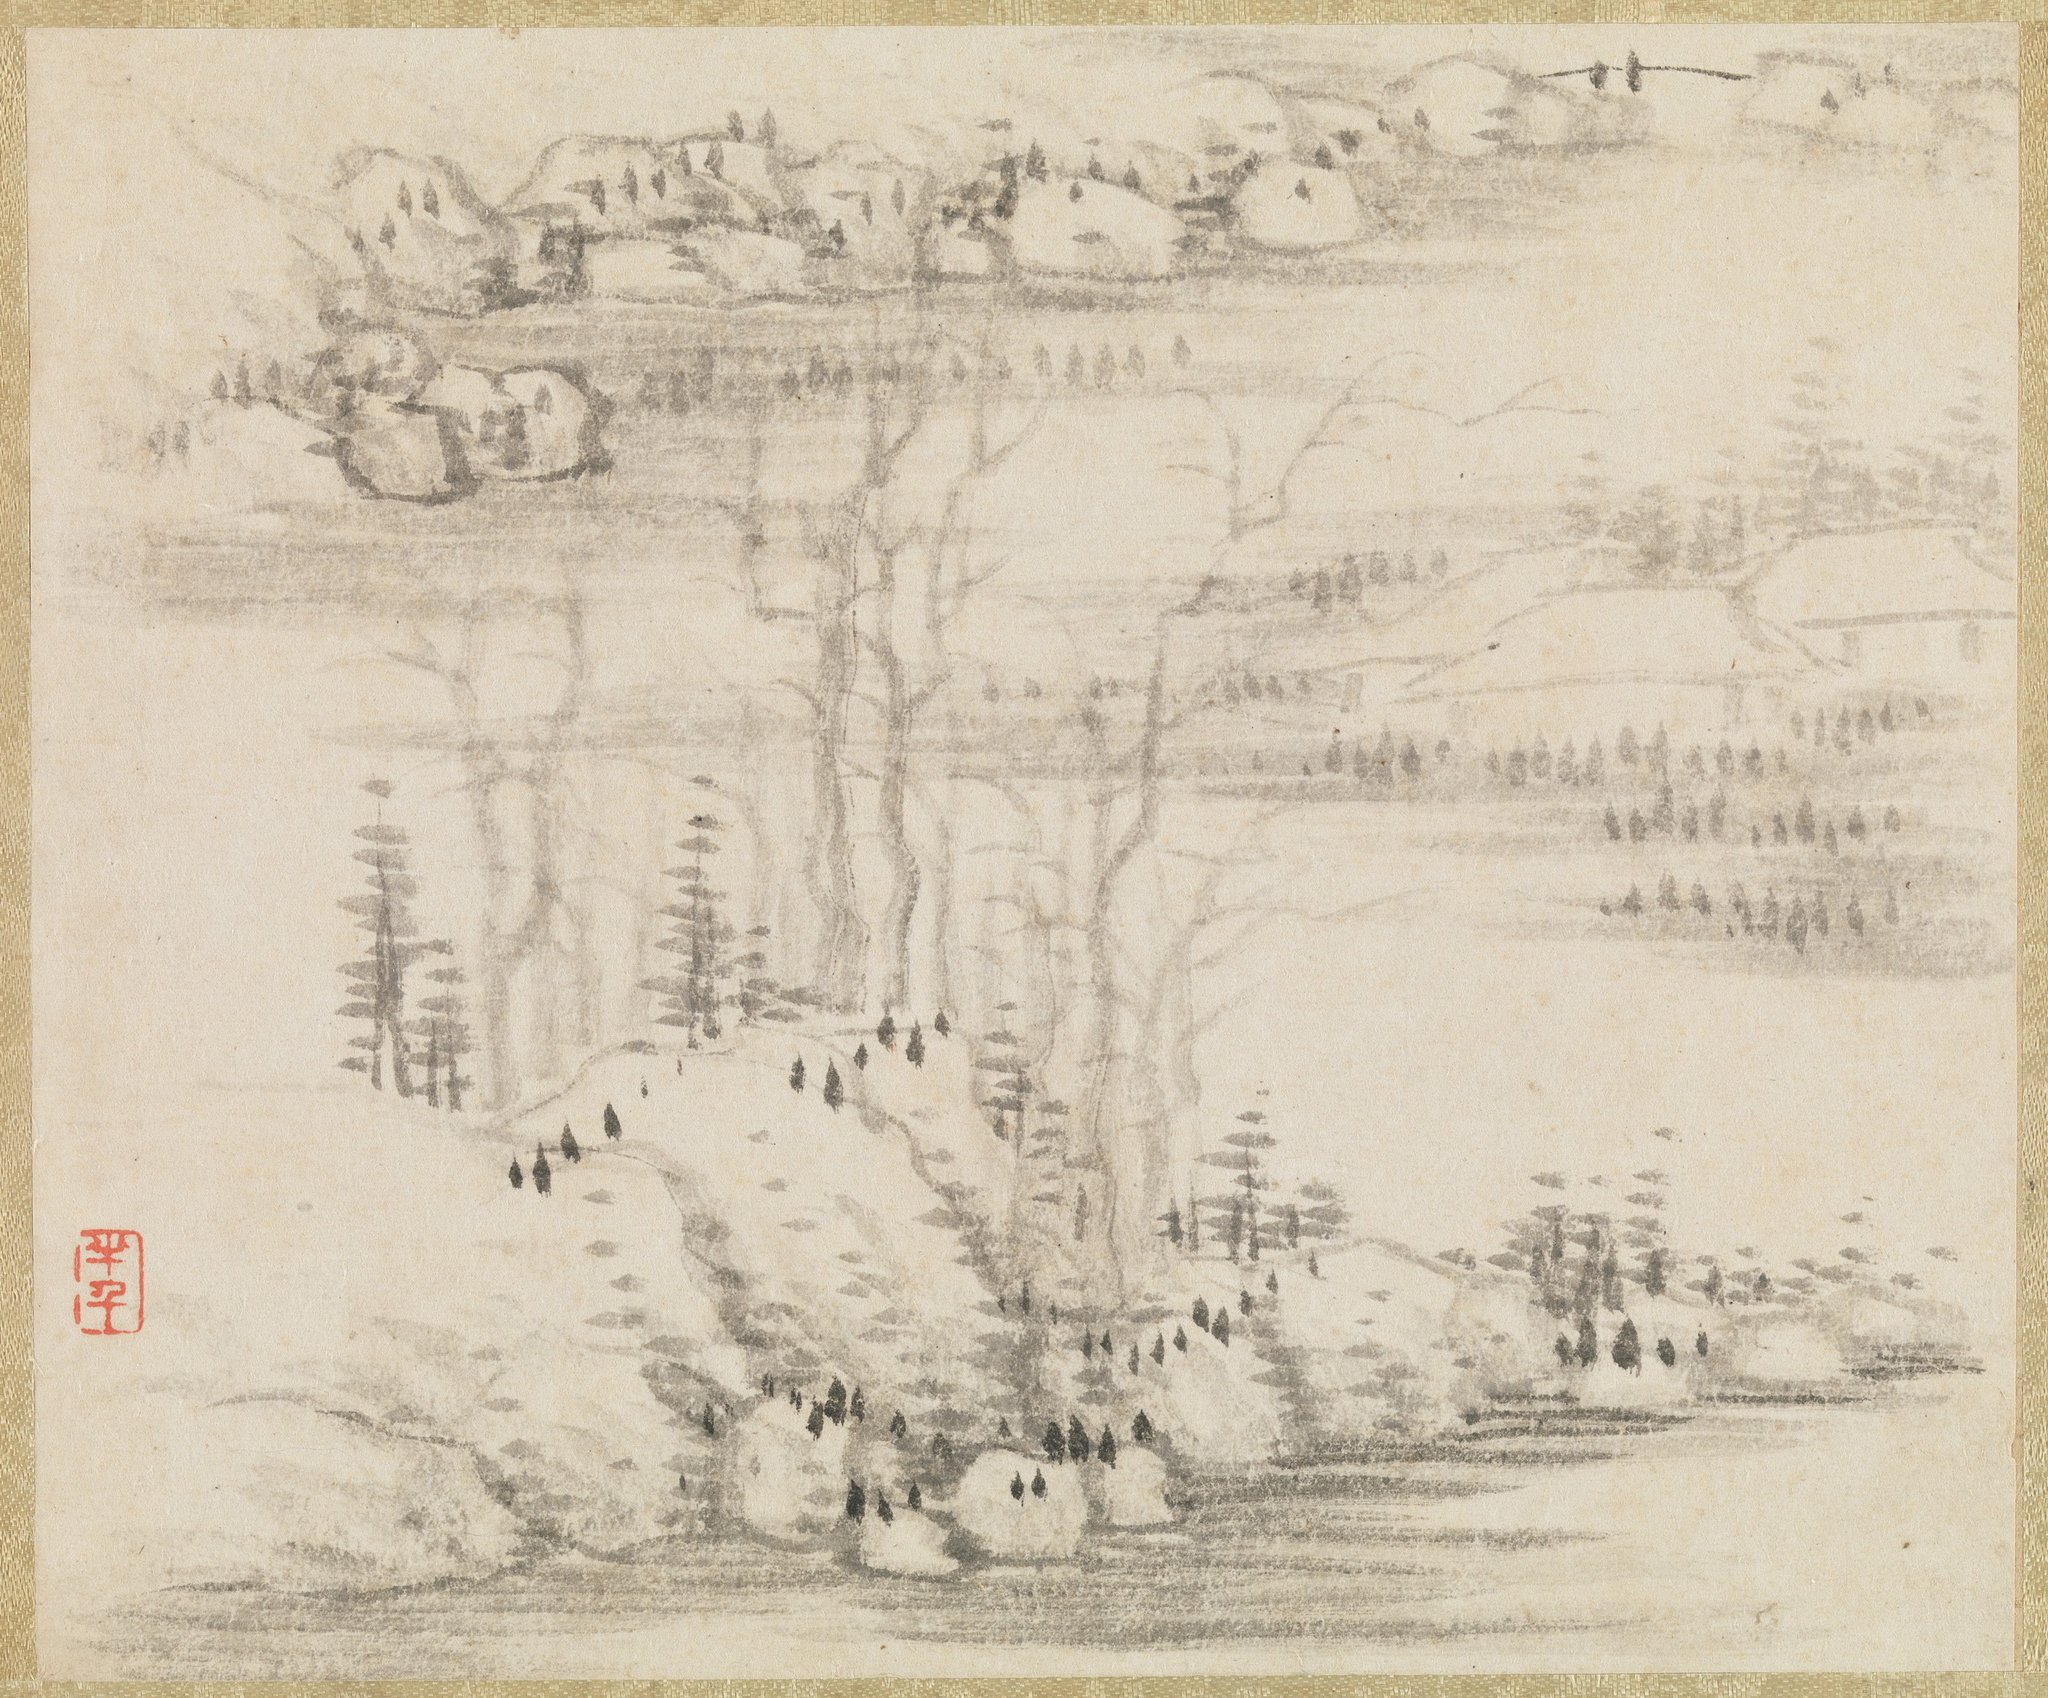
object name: album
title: Landscapes and trees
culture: chinese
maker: gong xian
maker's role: artist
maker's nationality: chinese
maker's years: 1619-1689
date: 1679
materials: ink, paper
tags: landscapes